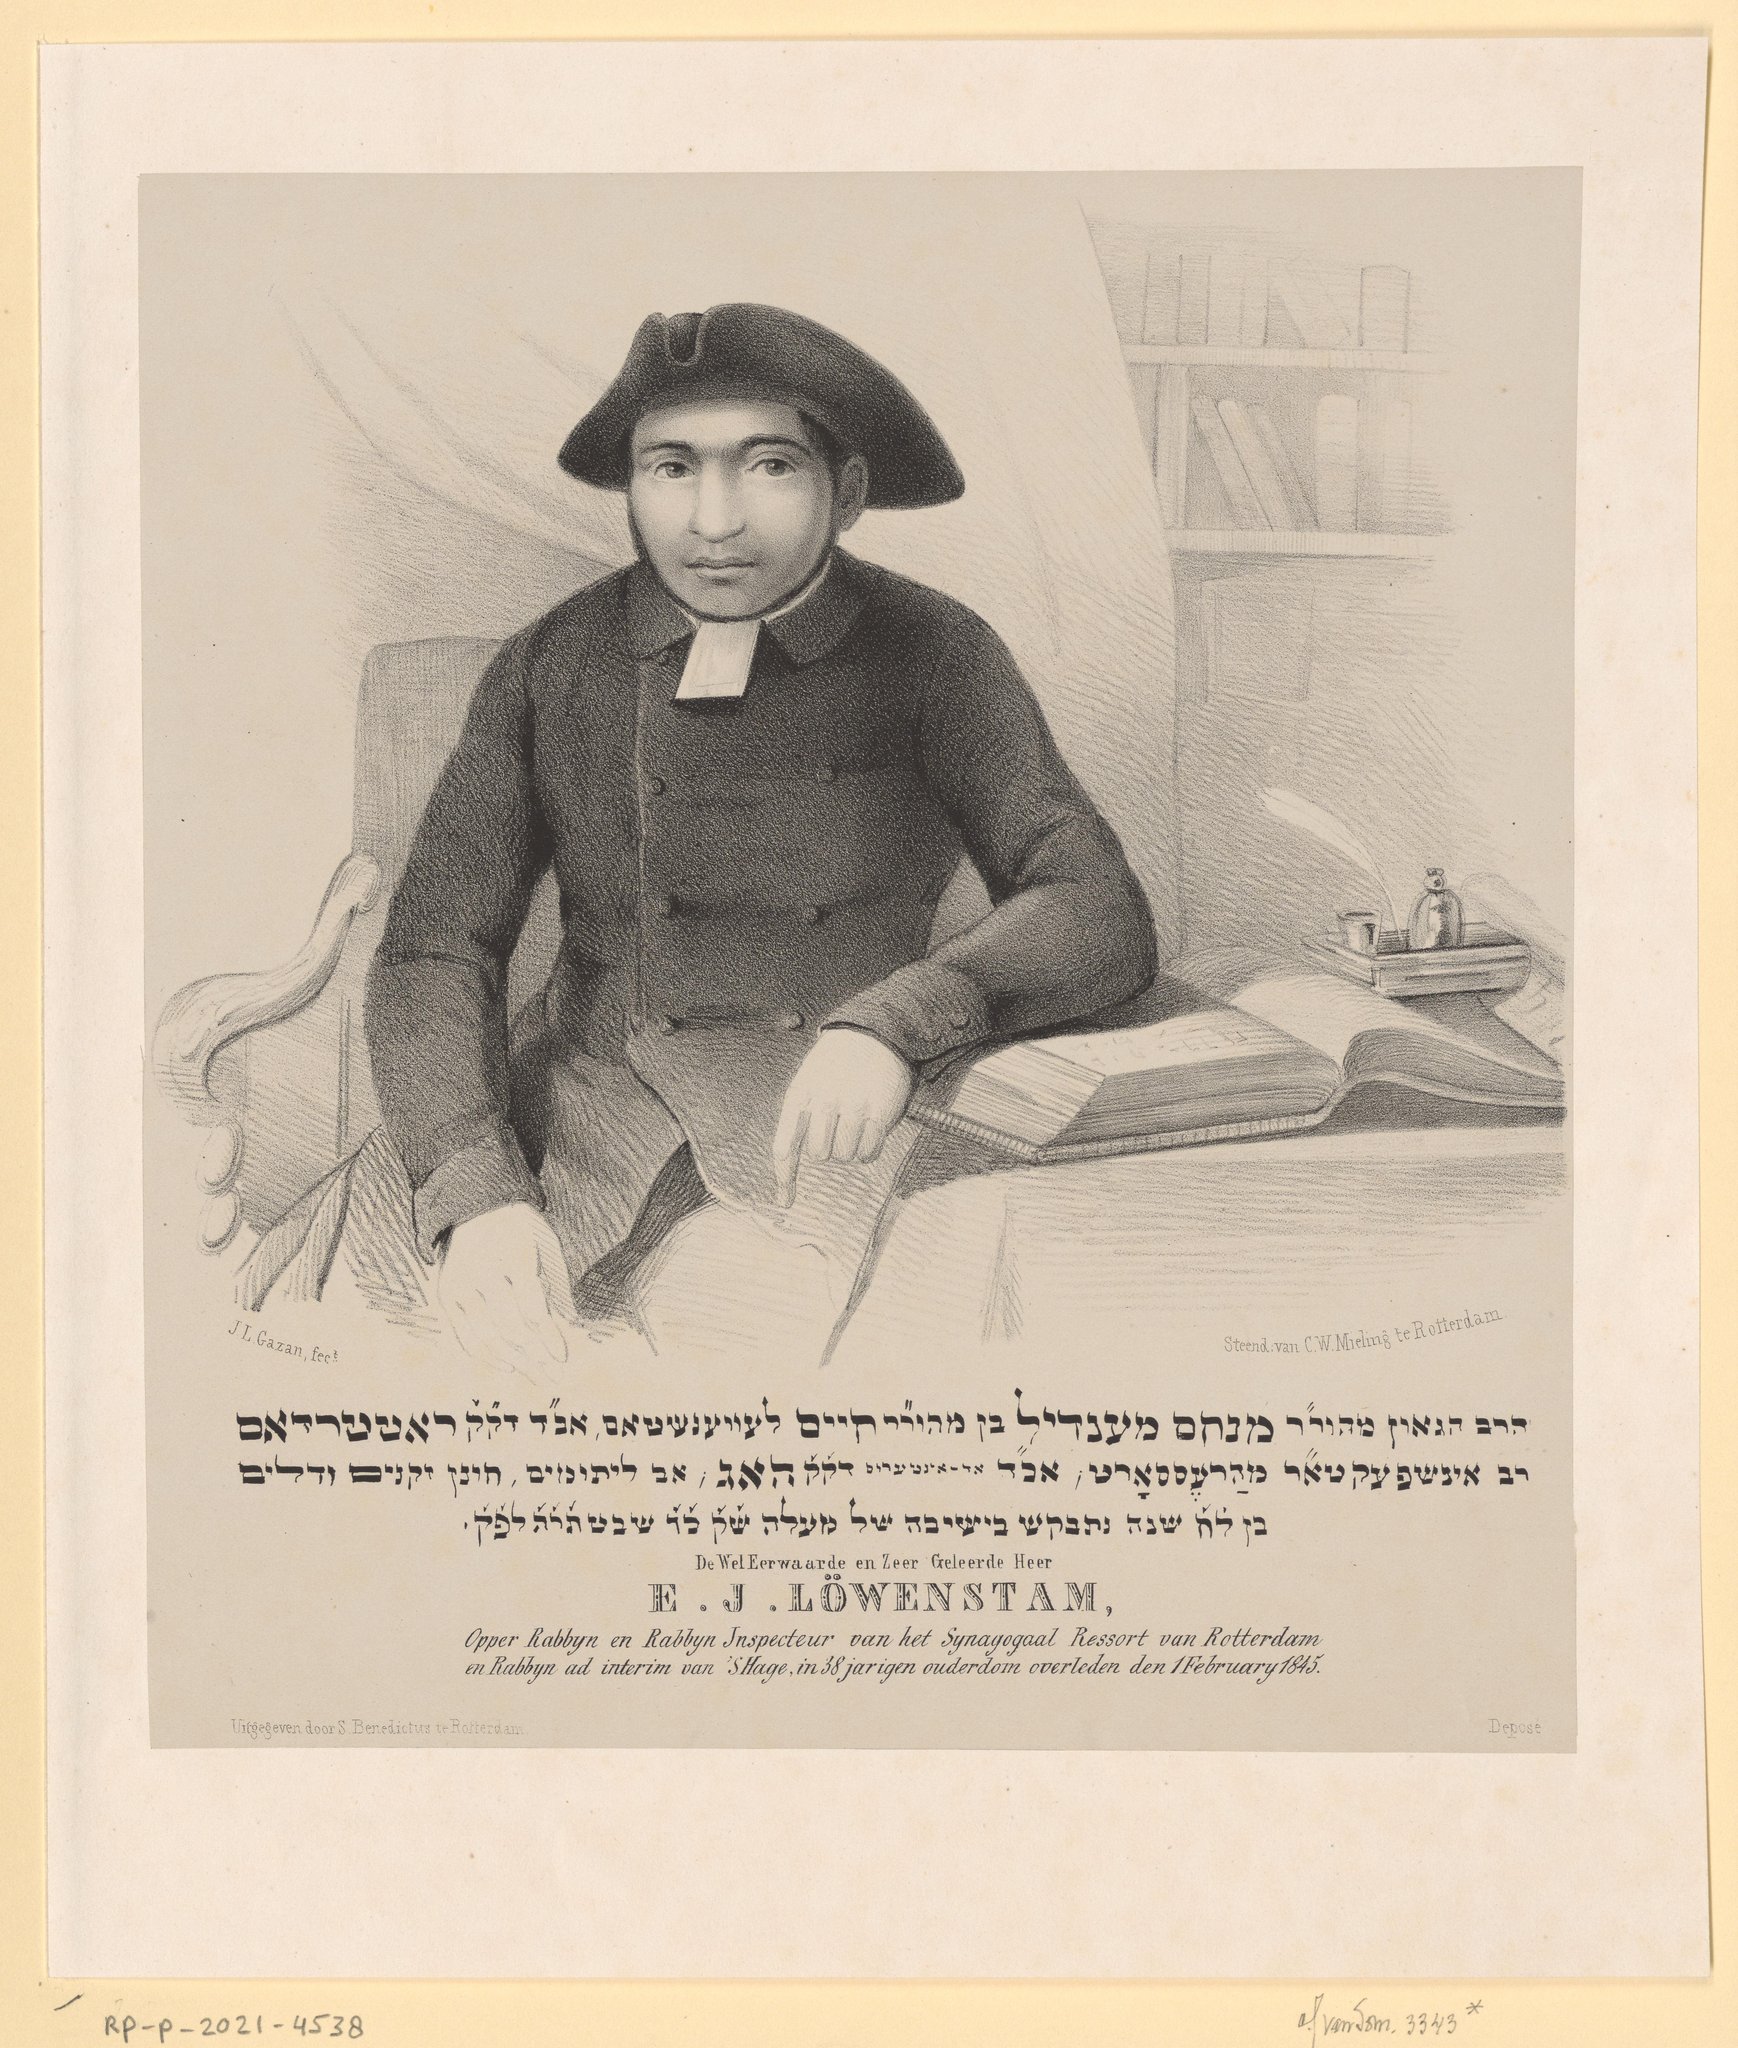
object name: print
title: Portret van Emanuel Joachim Löwenstam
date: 1845-1847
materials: paper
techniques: lithograph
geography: netherlands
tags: rotterdam, bookshelves, writing tools, historical persons, book - mm - book open, chief rabbi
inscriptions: : ‘Deposé.’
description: Met onderschrift in het Hebreeuws en Nederlands.